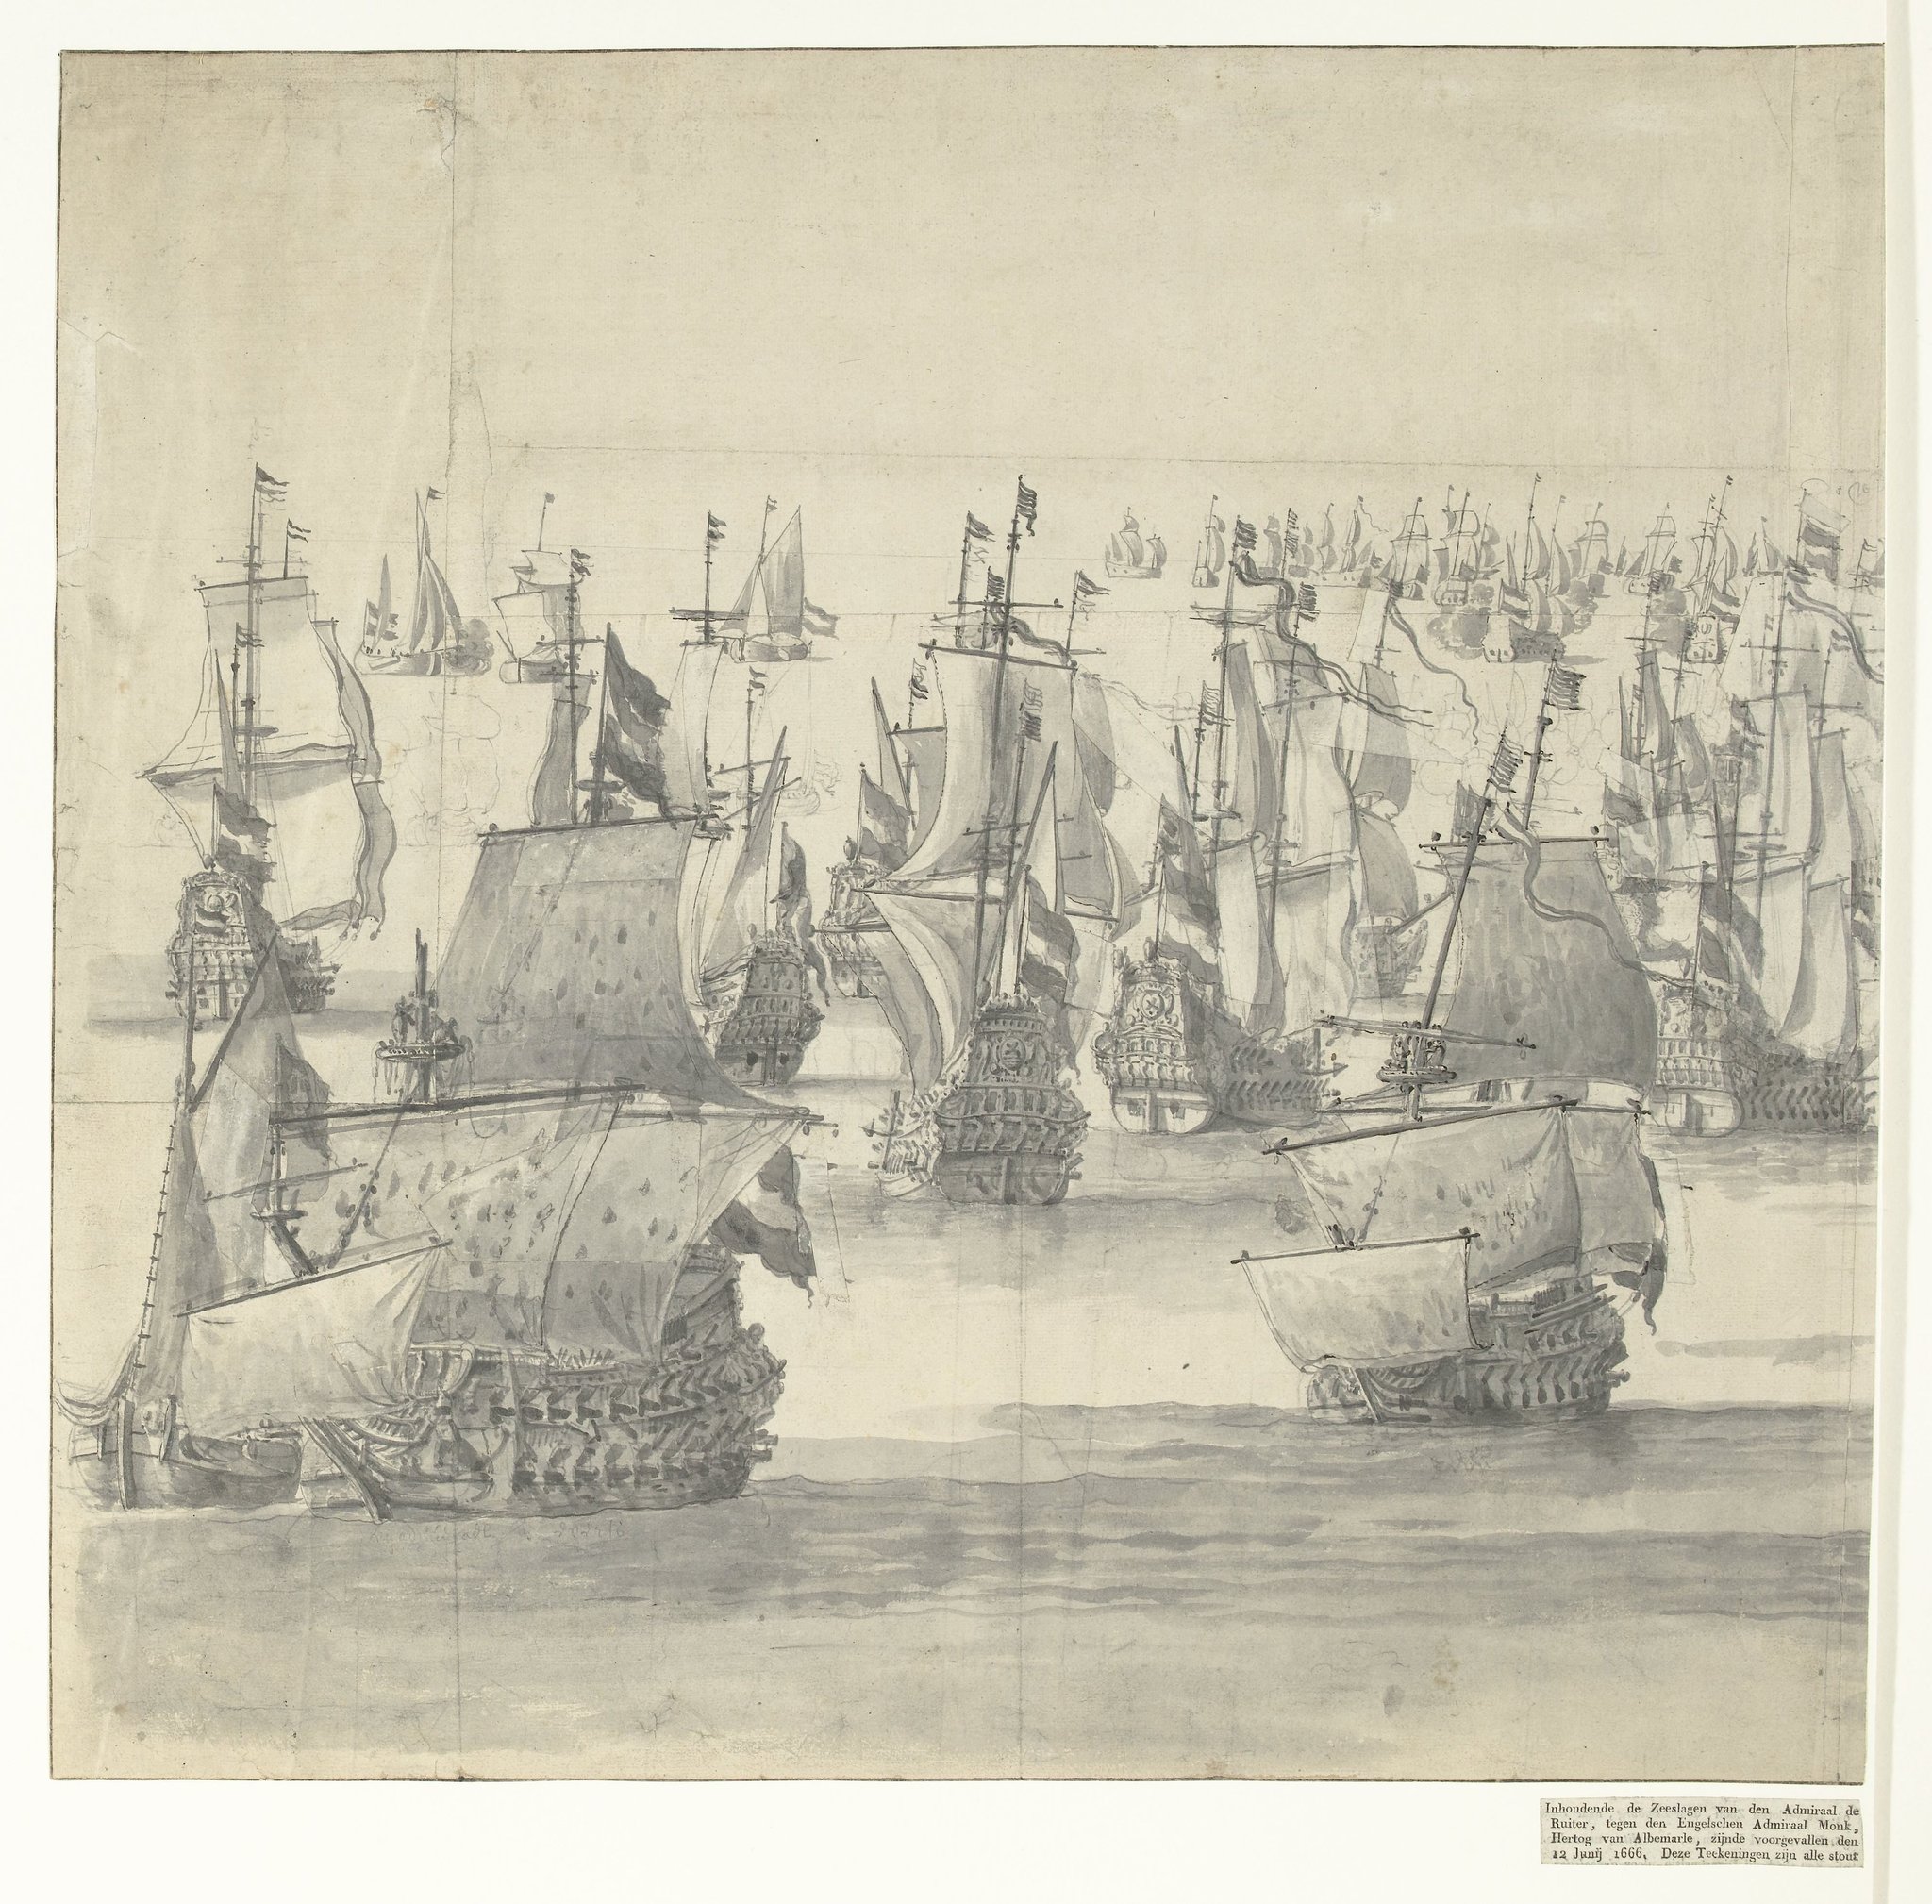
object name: drawing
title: Zeeslag bij Terheide, 10 augustus 1653 (linkerblad)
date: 1653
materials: ink, paper, pencil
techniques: brush, pen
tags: maarten harpertszoon tromp, sailing-ship, sailing-boat, sea (seascape), battle (+ sailing-ships), navy (+ sailing-ships), battle of scheveningen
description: De zeeslag bij Terheide, 10 augustus 1653, episode uit de Eerste Engelse Zeeoorlog (1652-1654). Slag tussen Nederlandse en Engelse oorlogsschepen. Het linkerblad van een grote voorstelling samengesteld uit drie bladen.